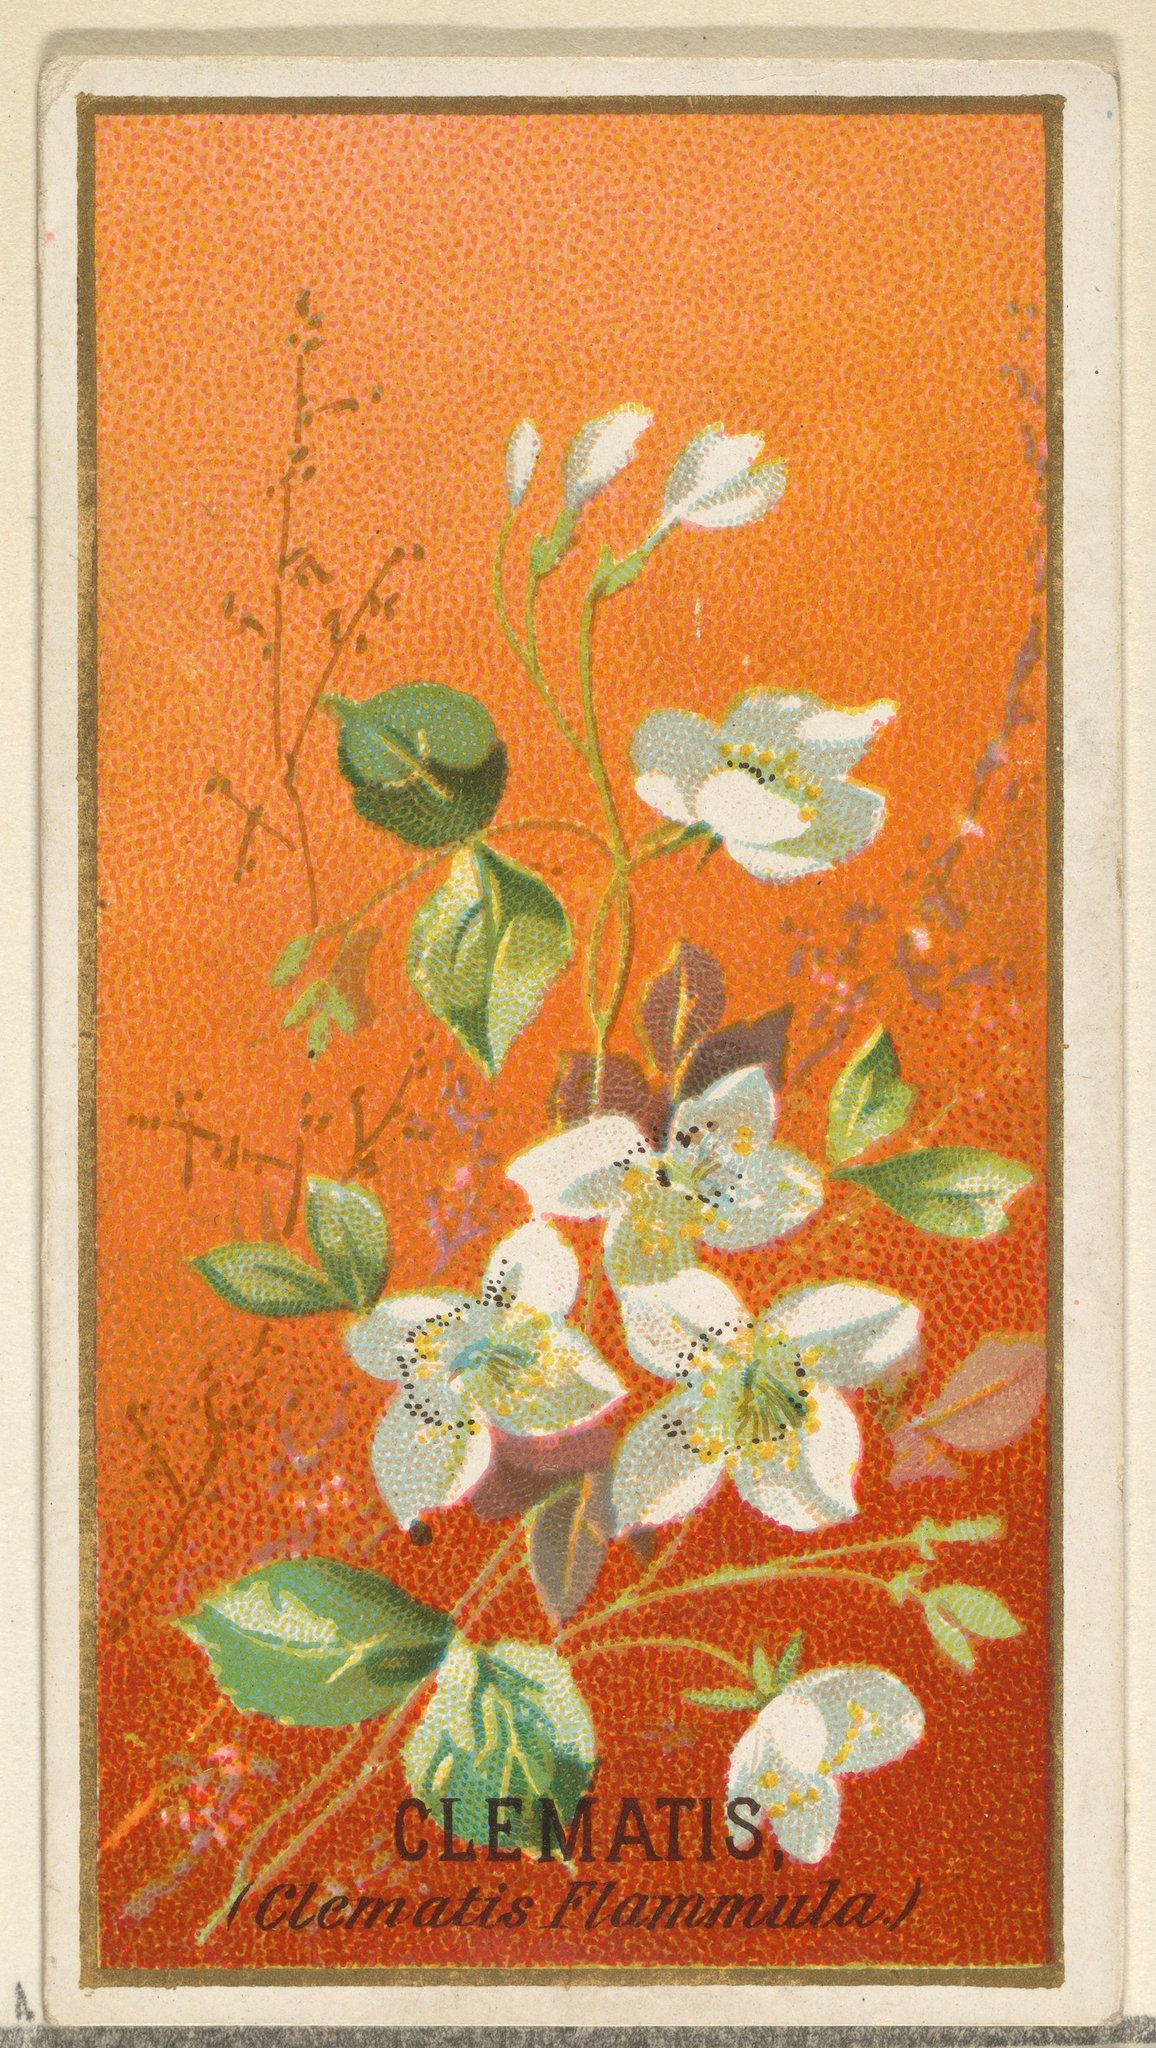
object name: print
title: Clemantis (Clemantis Flammula), from the Flowers series for Old Judge Cigarettes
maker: goodwin & company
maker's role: publisher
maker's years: 1850-1950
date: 1890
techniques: color lithograph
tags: flowers